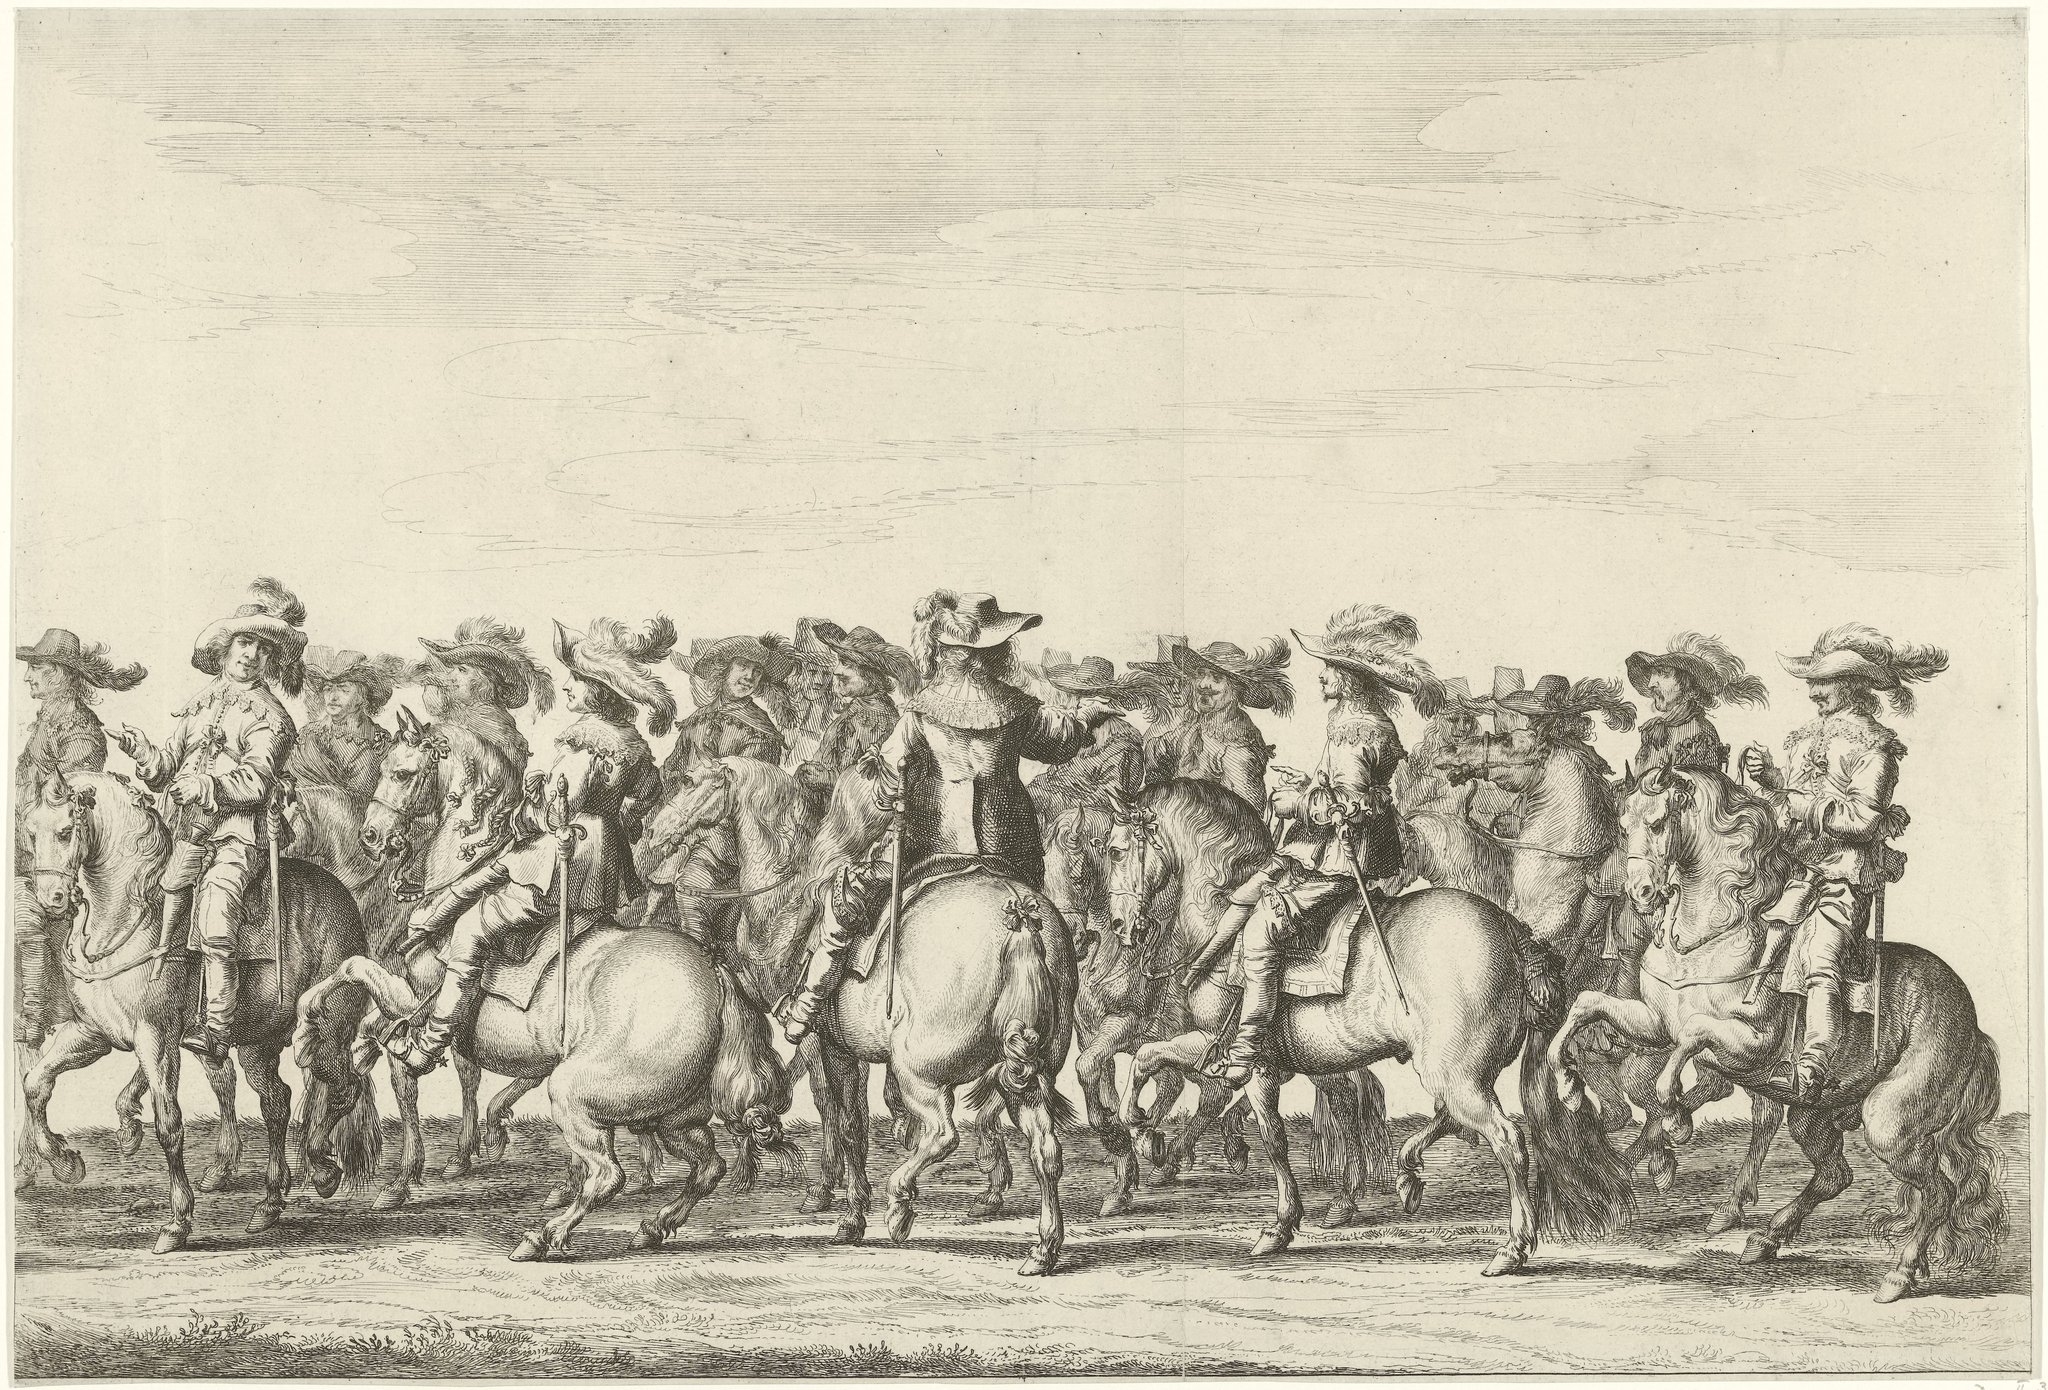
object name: print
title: Intocht van Maria Henrietta Stuart, prinses van Oranje te Amsterdam (plaat 3)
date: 1660-1662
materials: paper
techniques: engraving, etching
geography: northern netherlands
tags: triumphal entry and public reception, pageant, 'entrée solennelle', 'joyeuse entrée'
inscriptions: collector's mark: Lugt 2228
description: Bezoek van Maria Henrietta Stuart, prinses van Oranje, vergezeld door Amalia van Solms, de jonge prins Willem III en anderen te Amsterdam, 15 juni 1660. De stoet met ruiters. Derde plaat in een ongemonteerd ensemble van de stoet bestaande uit zeven bladen.